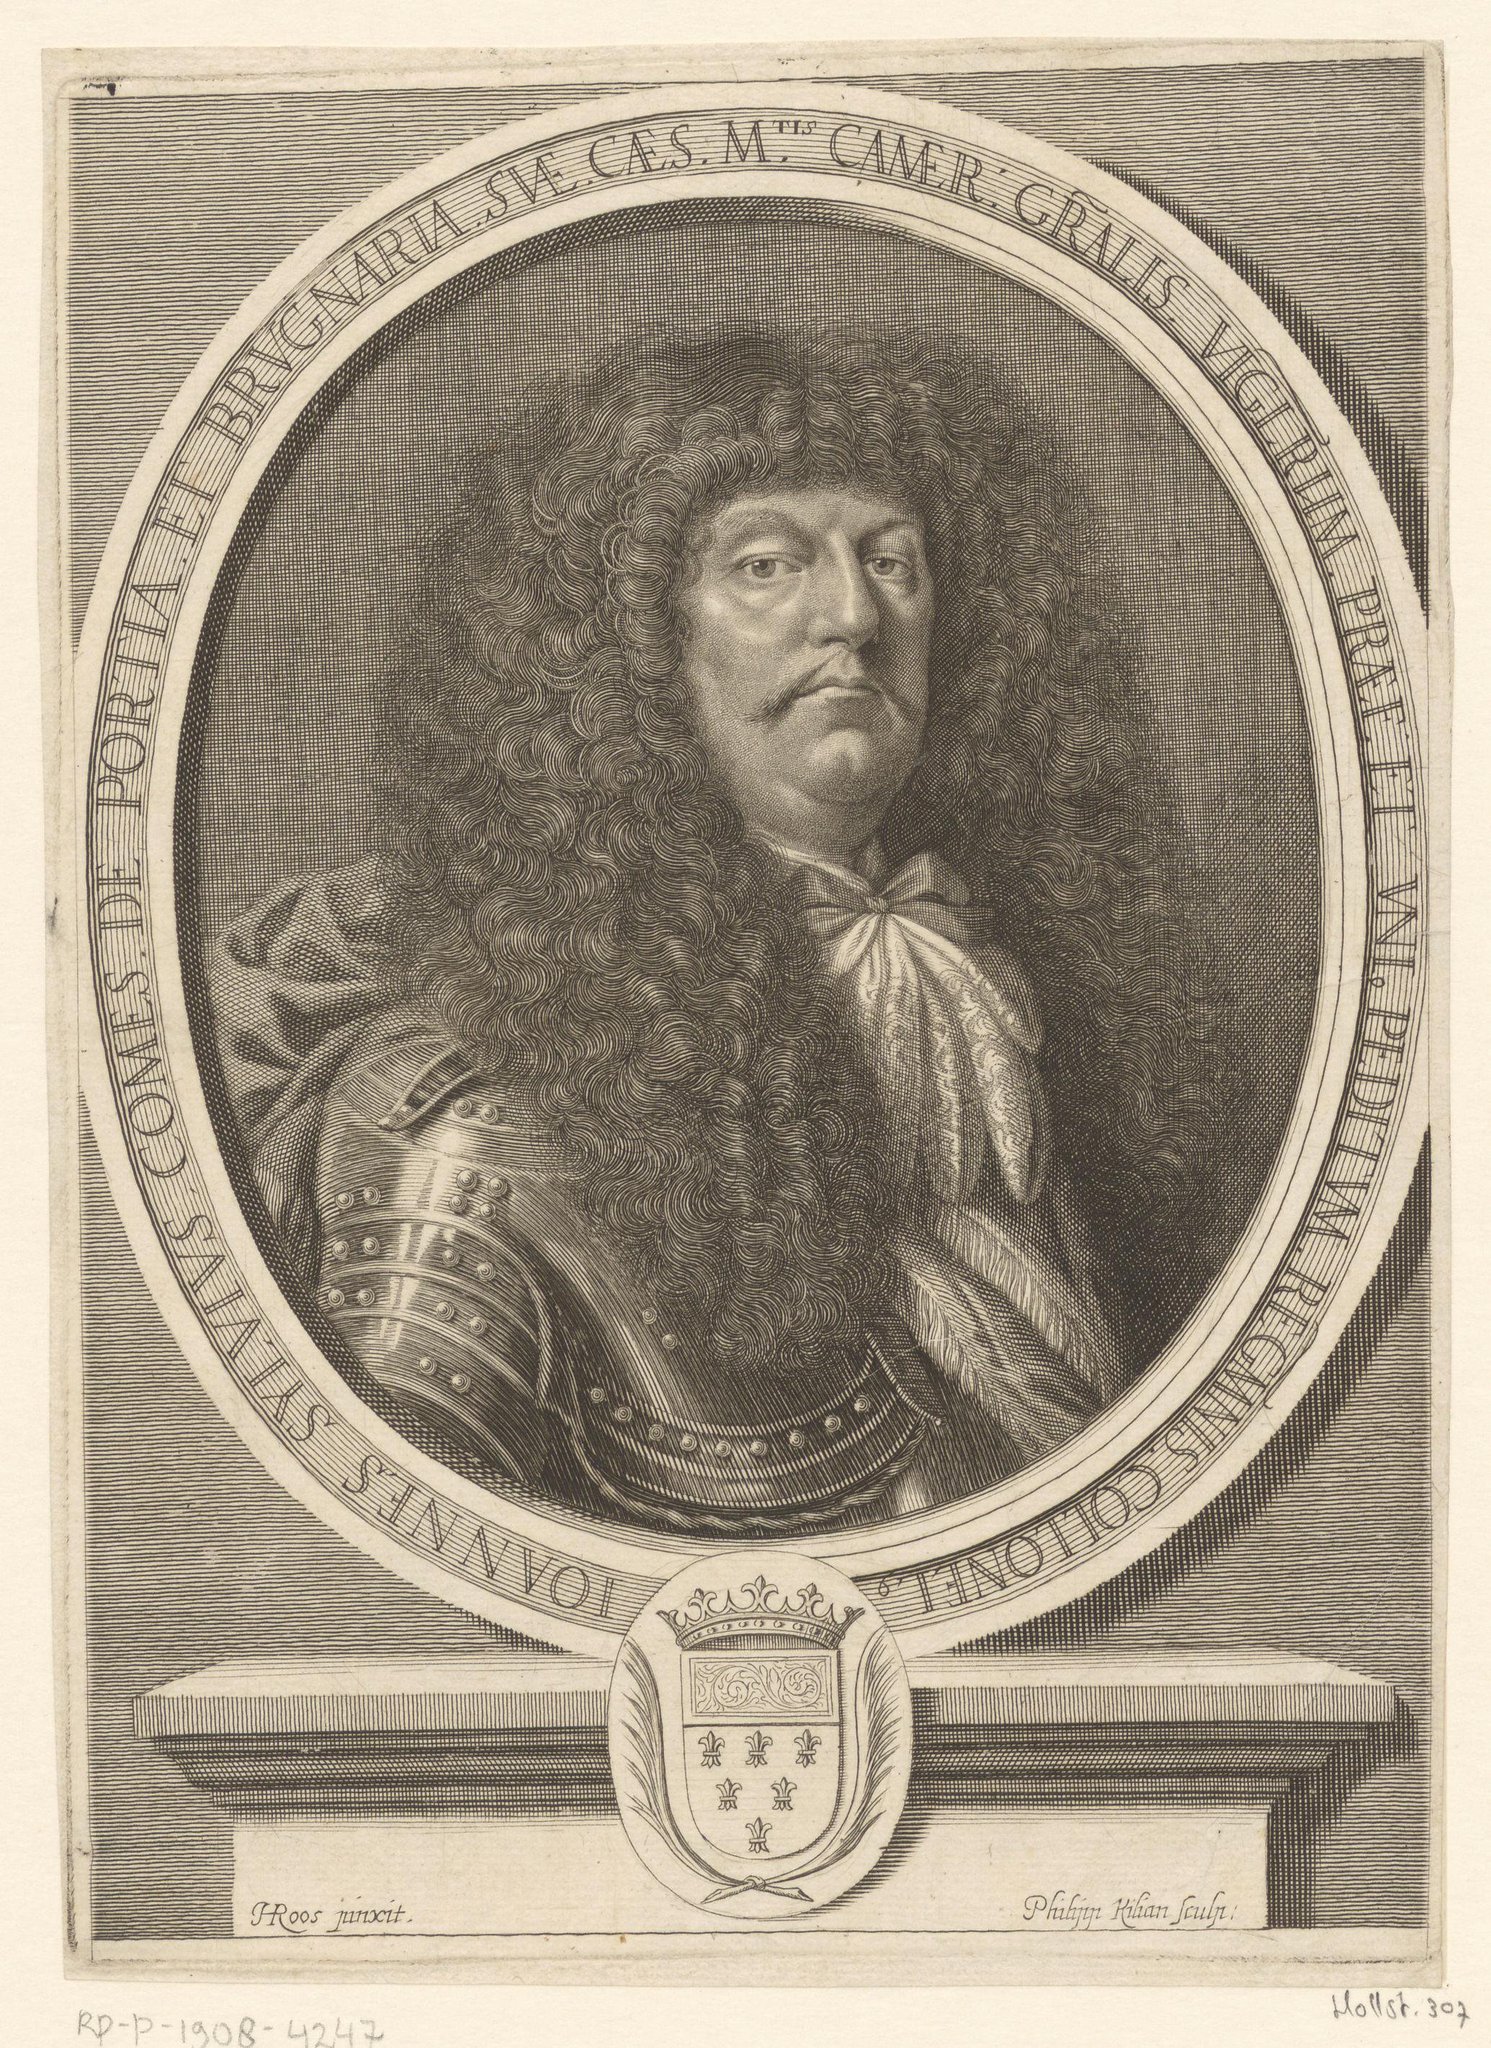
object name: print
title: Portret van Johannes Sylvius, graaf van Porcia en Brugnato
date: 1641-1693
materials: paper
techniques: engraving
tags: commander-in-chief, general, marshal, historical persons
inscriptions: collector's mark: Lugt 2228